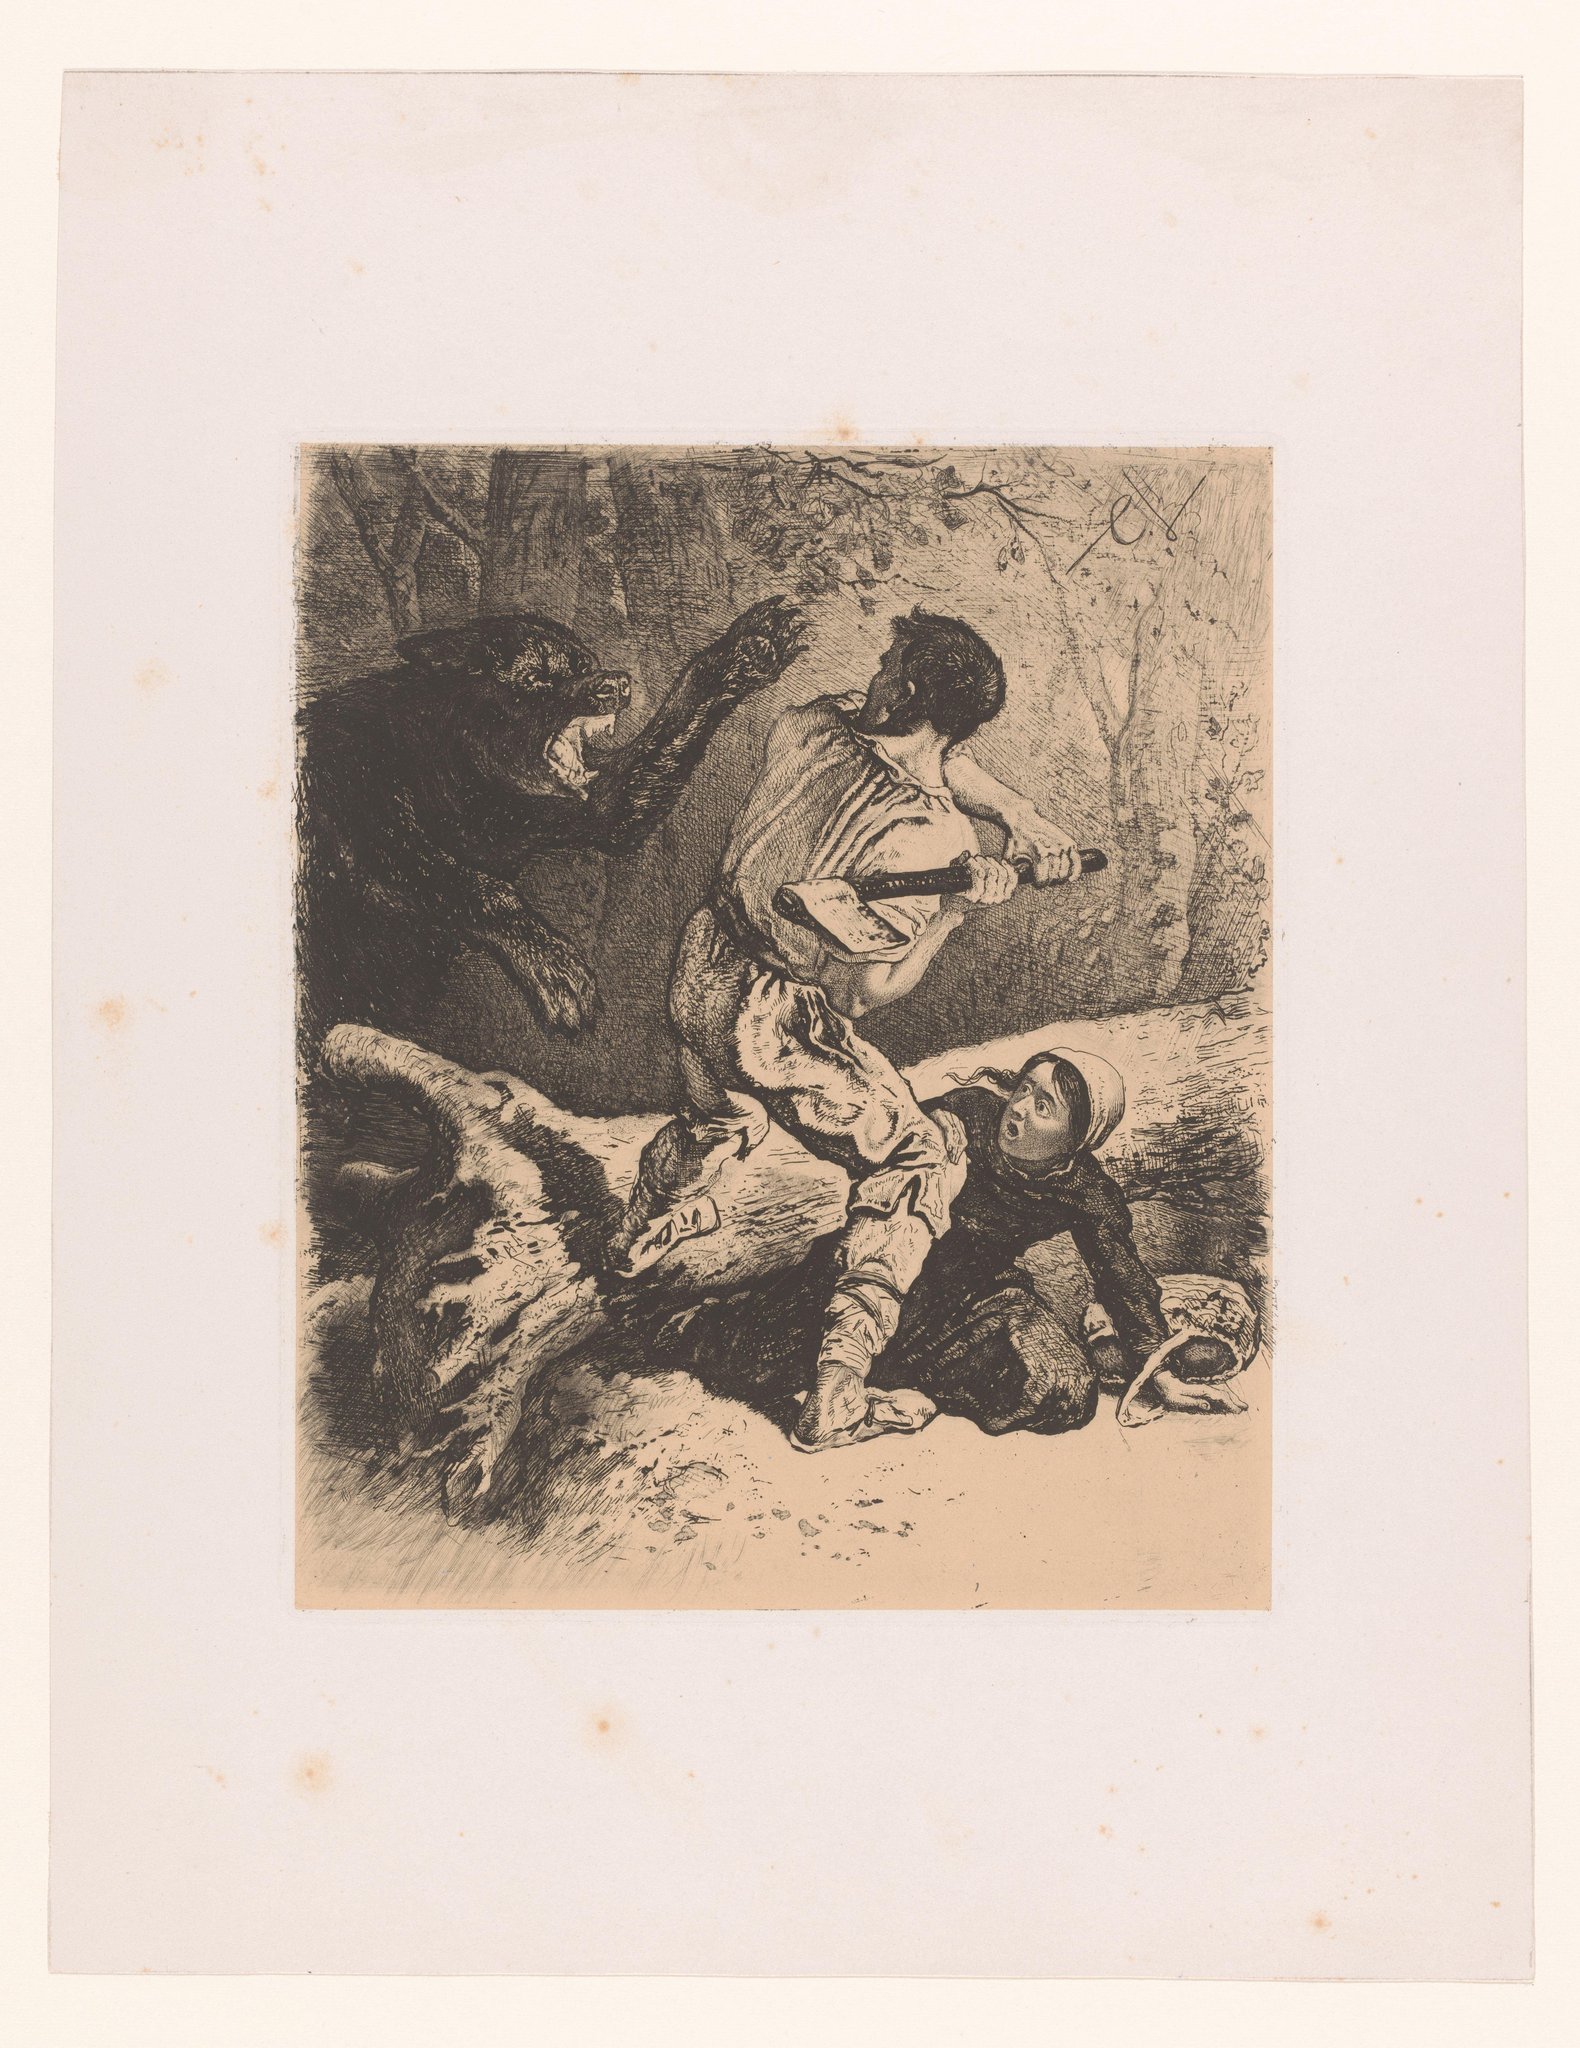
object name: print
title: Houthakker aangevallen door een beer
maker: charles verlat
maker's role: painter, print maker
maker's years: 1824-1890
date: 1860-1888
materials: paper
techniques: drypoint, etching, retroussage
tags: animals threatening man, beasts of prey, predatory animals: bear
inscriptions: collector's mark: Lugt 2228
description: Prent naar het schilderij van Charles Verlat getiteld "Strijd op het leven en dood".